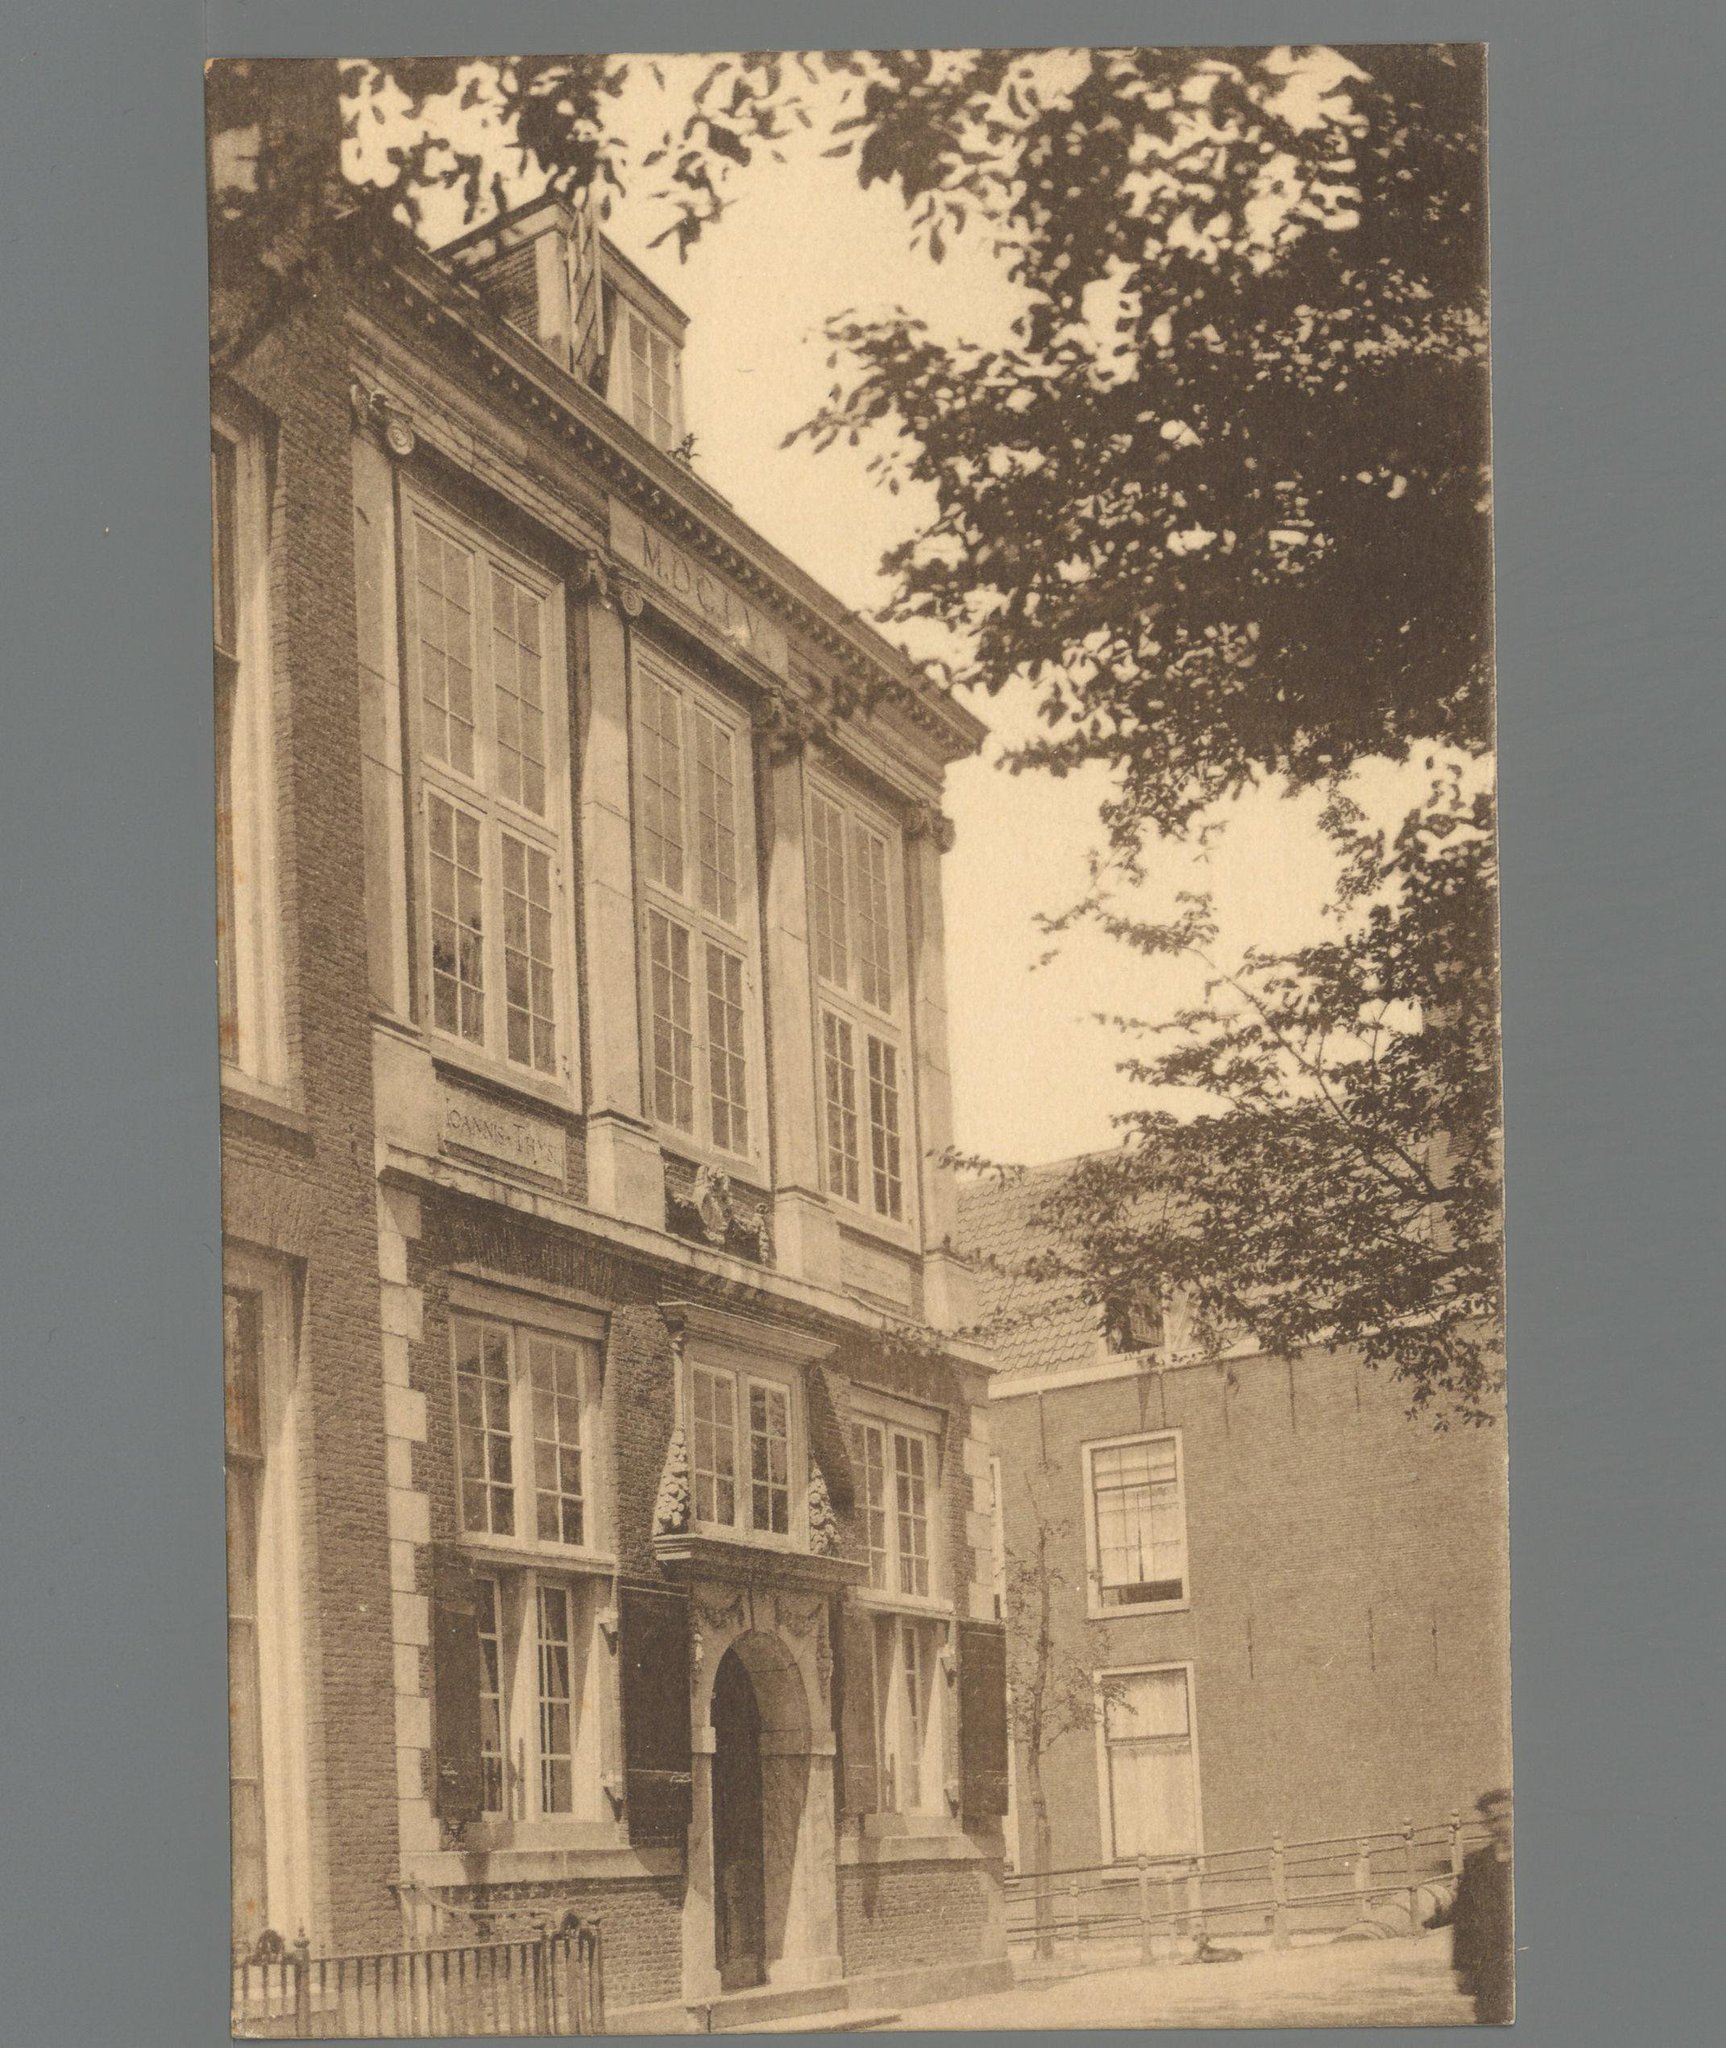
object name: photomechanical print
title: Leiden. Bibliotheca Thijsiana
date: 1905-1930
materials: cardboard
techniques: photograph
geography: leiden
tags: public library